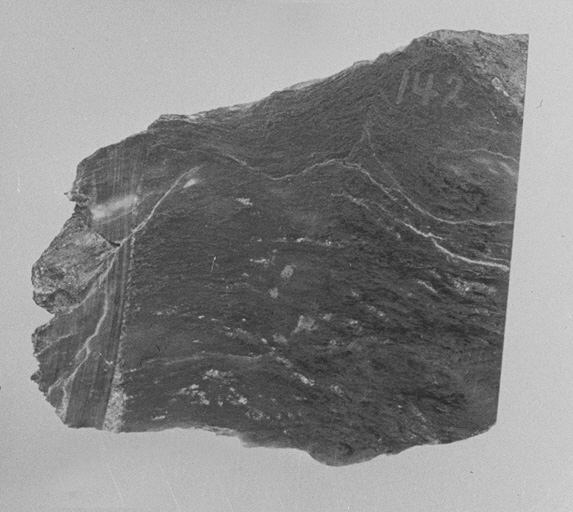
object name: fragment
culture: german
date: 1902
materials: jade